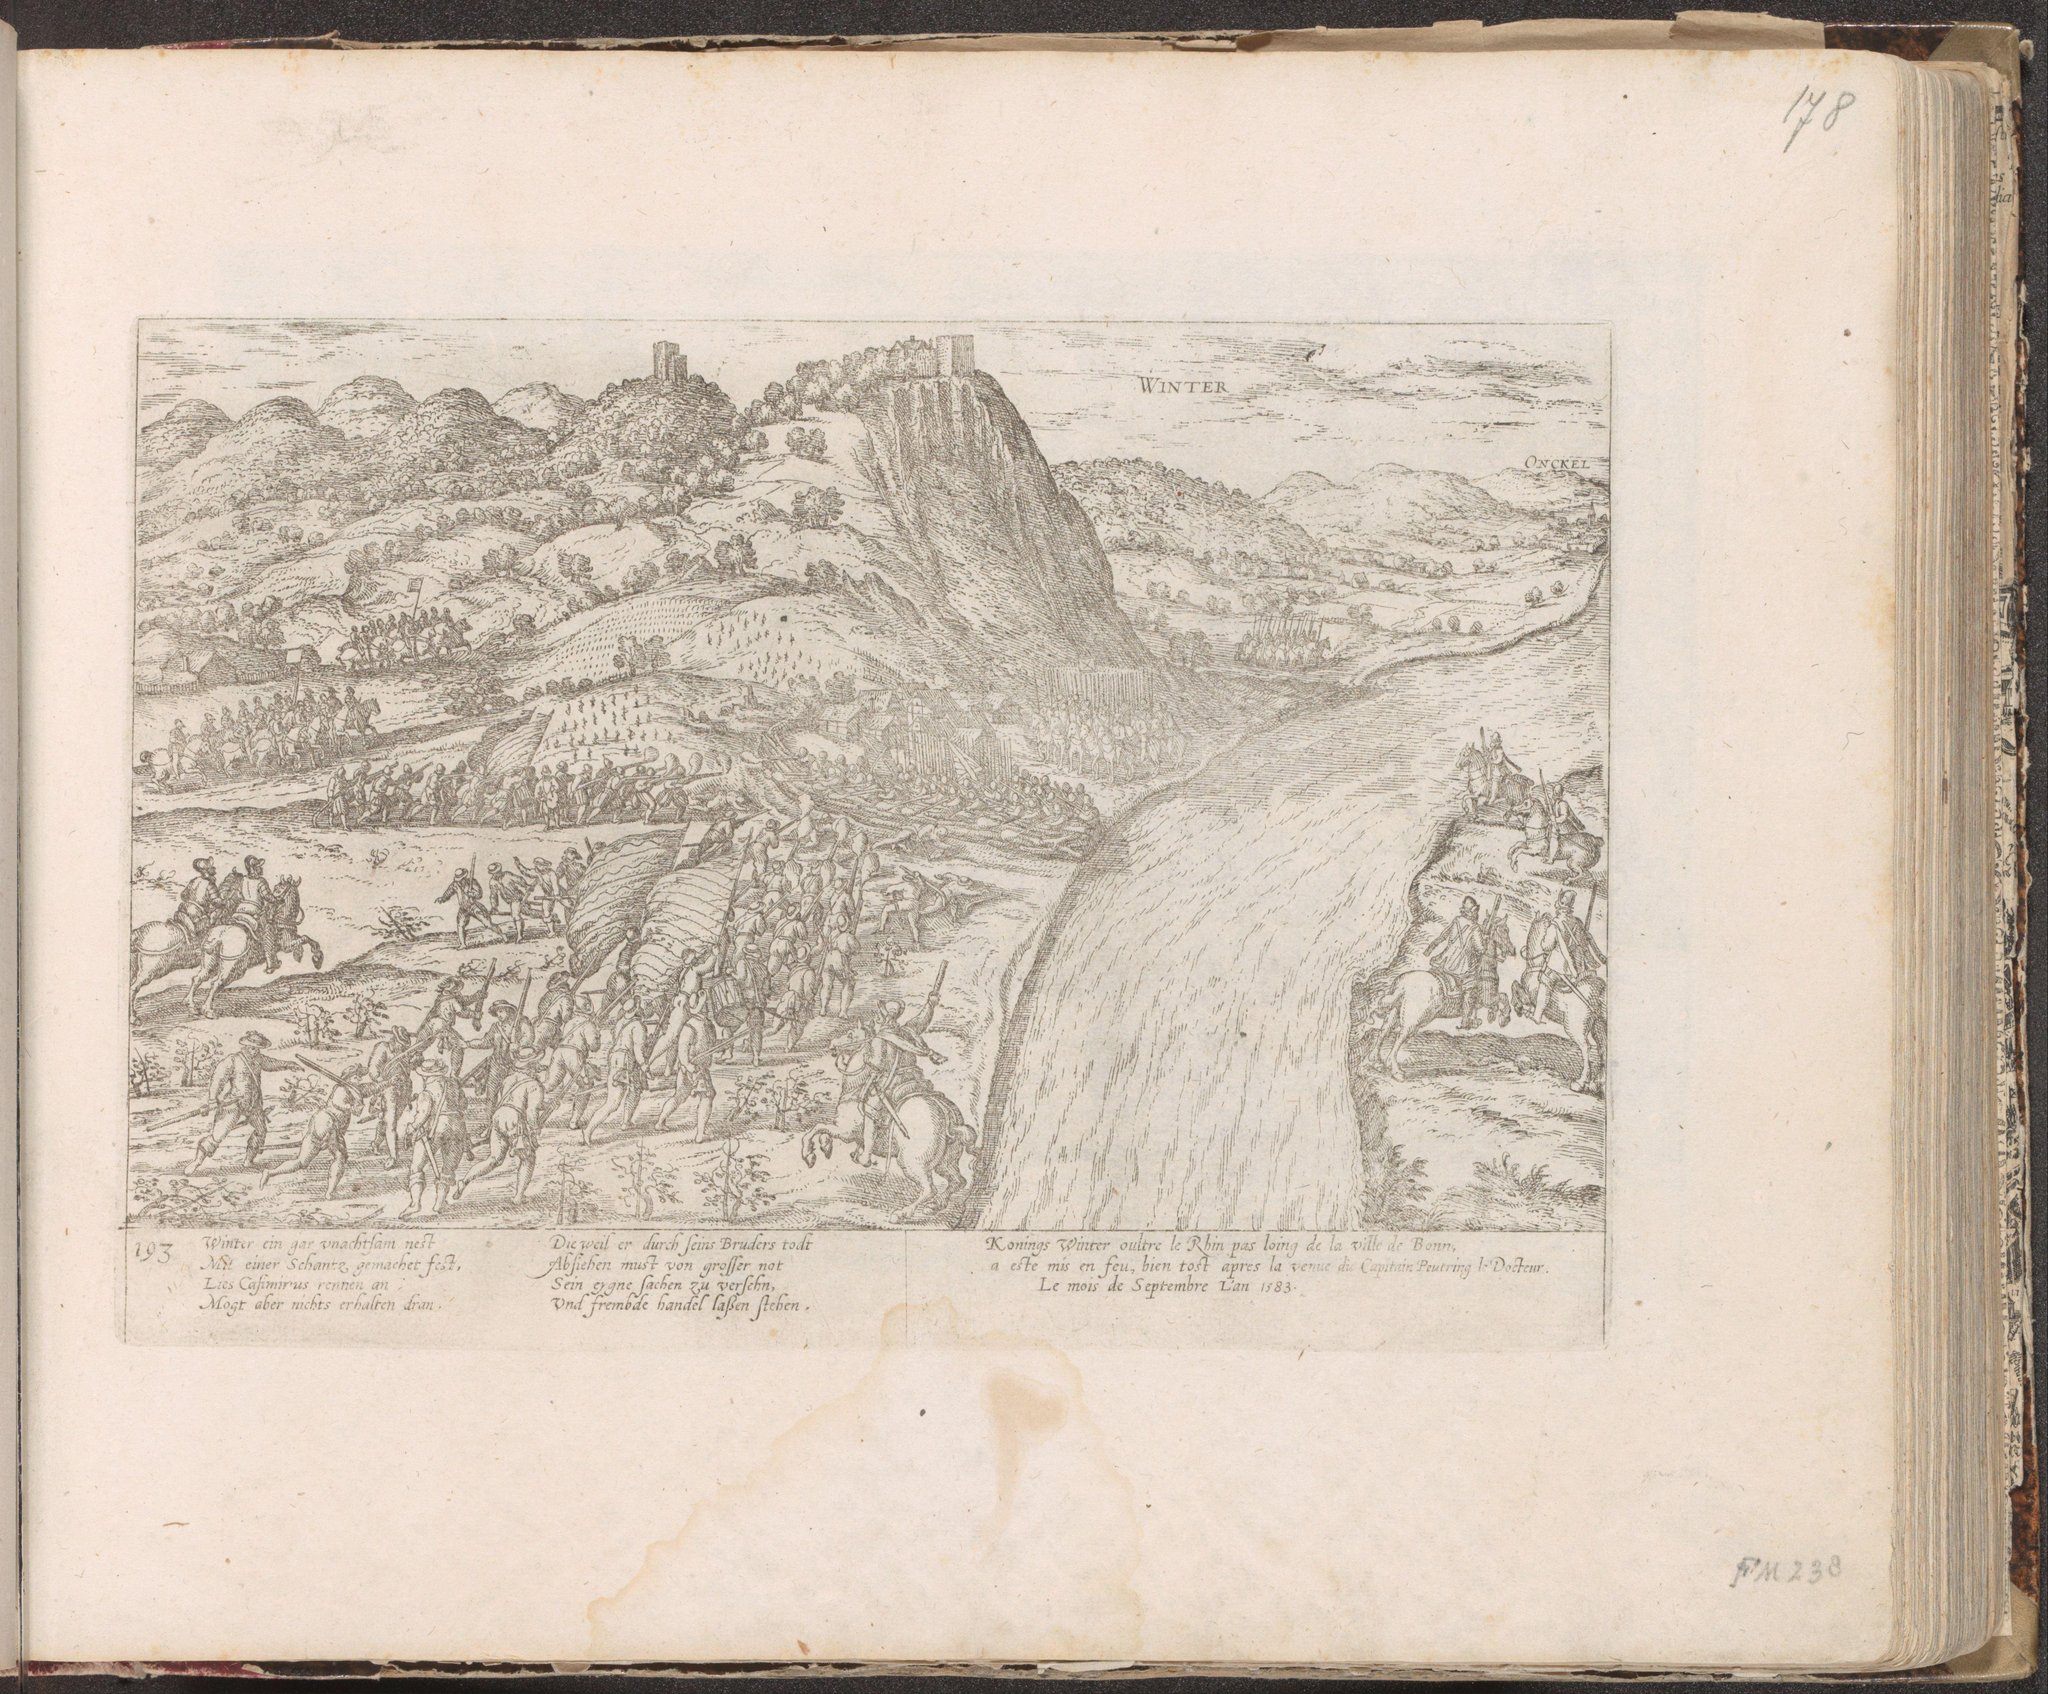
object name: album leaf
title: Beschieting van Königswinter, 1583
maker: frans hogenberg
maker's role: print maker, publisher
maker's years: 1538-1590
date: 1587-1591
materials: paper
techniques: etching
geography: cologne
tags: battle, fighting in general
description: Beschieting van Königswinter, september 1583. Episode uit de Keulse Oorlog. Met onderschrift van 8 regels in het Duits en 4 regels in het Frans. Linksonder genummerd: 193. De prent maakt deel uit van een album.